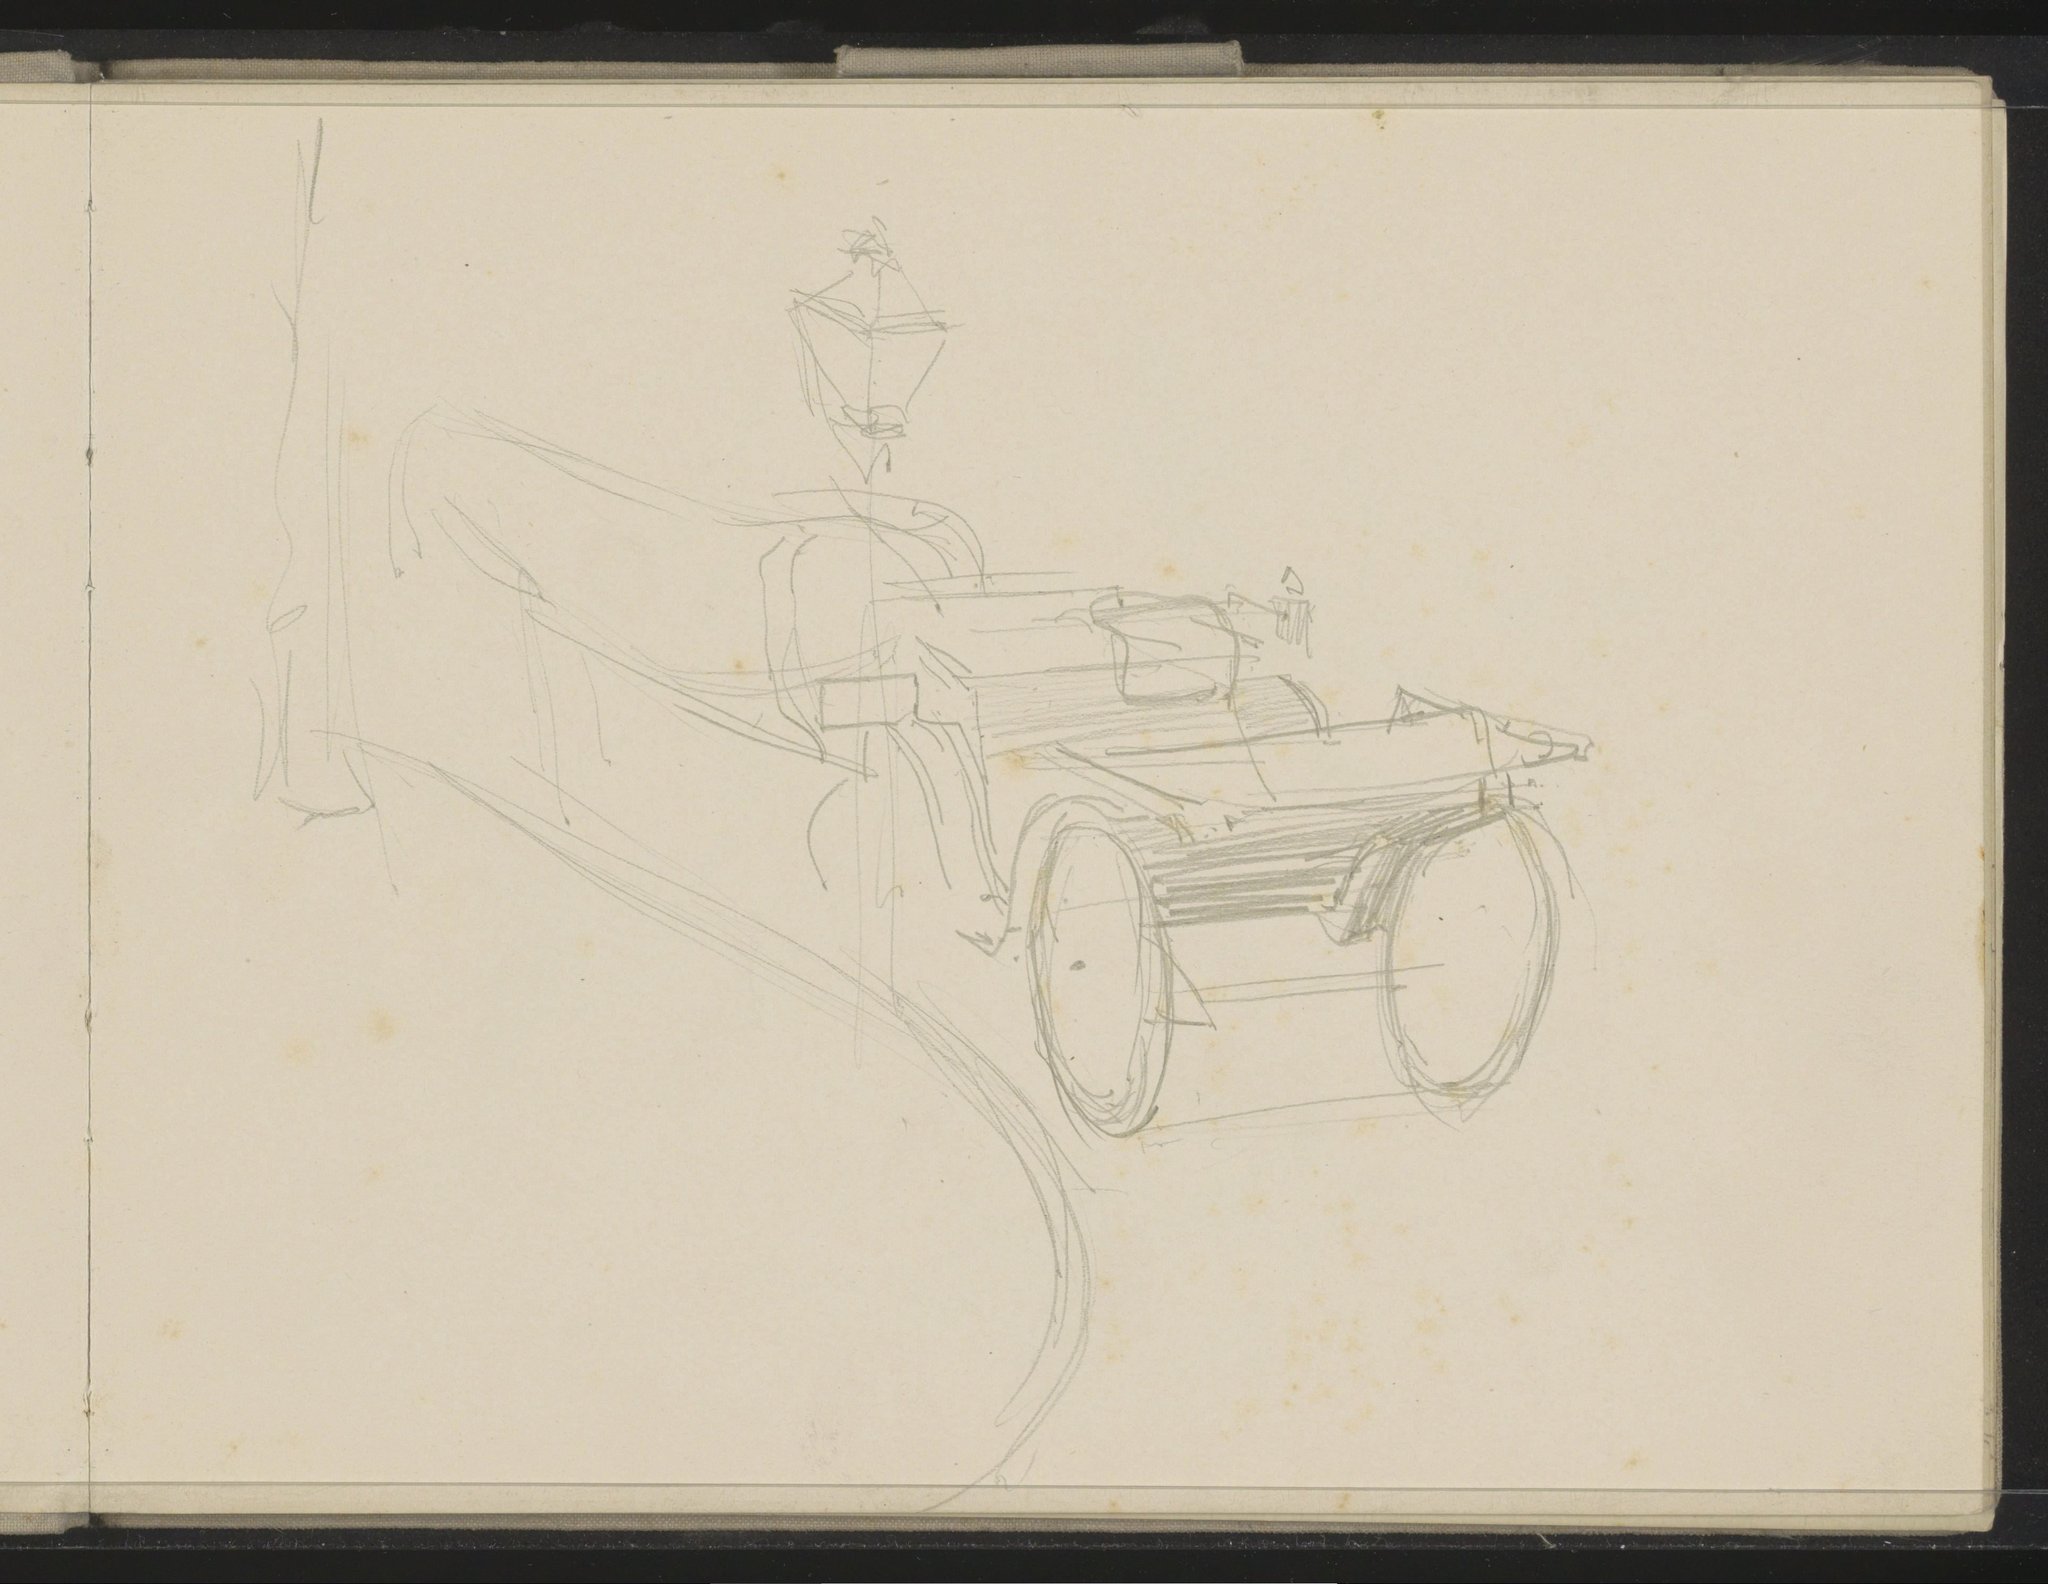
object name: sketchbook leaf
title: Paardenkoets langs een stoep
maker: ferdinand oldewelt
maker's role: draughtsman, print maker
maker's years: 1857-1935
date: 1908-1923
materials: paper, pencil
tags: four-wheeled vehicle drawn by one animal, street lighting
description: Op de straat staat een lantarenpaal. Blad 4 recto uit een schetsboek met 35 bladen.